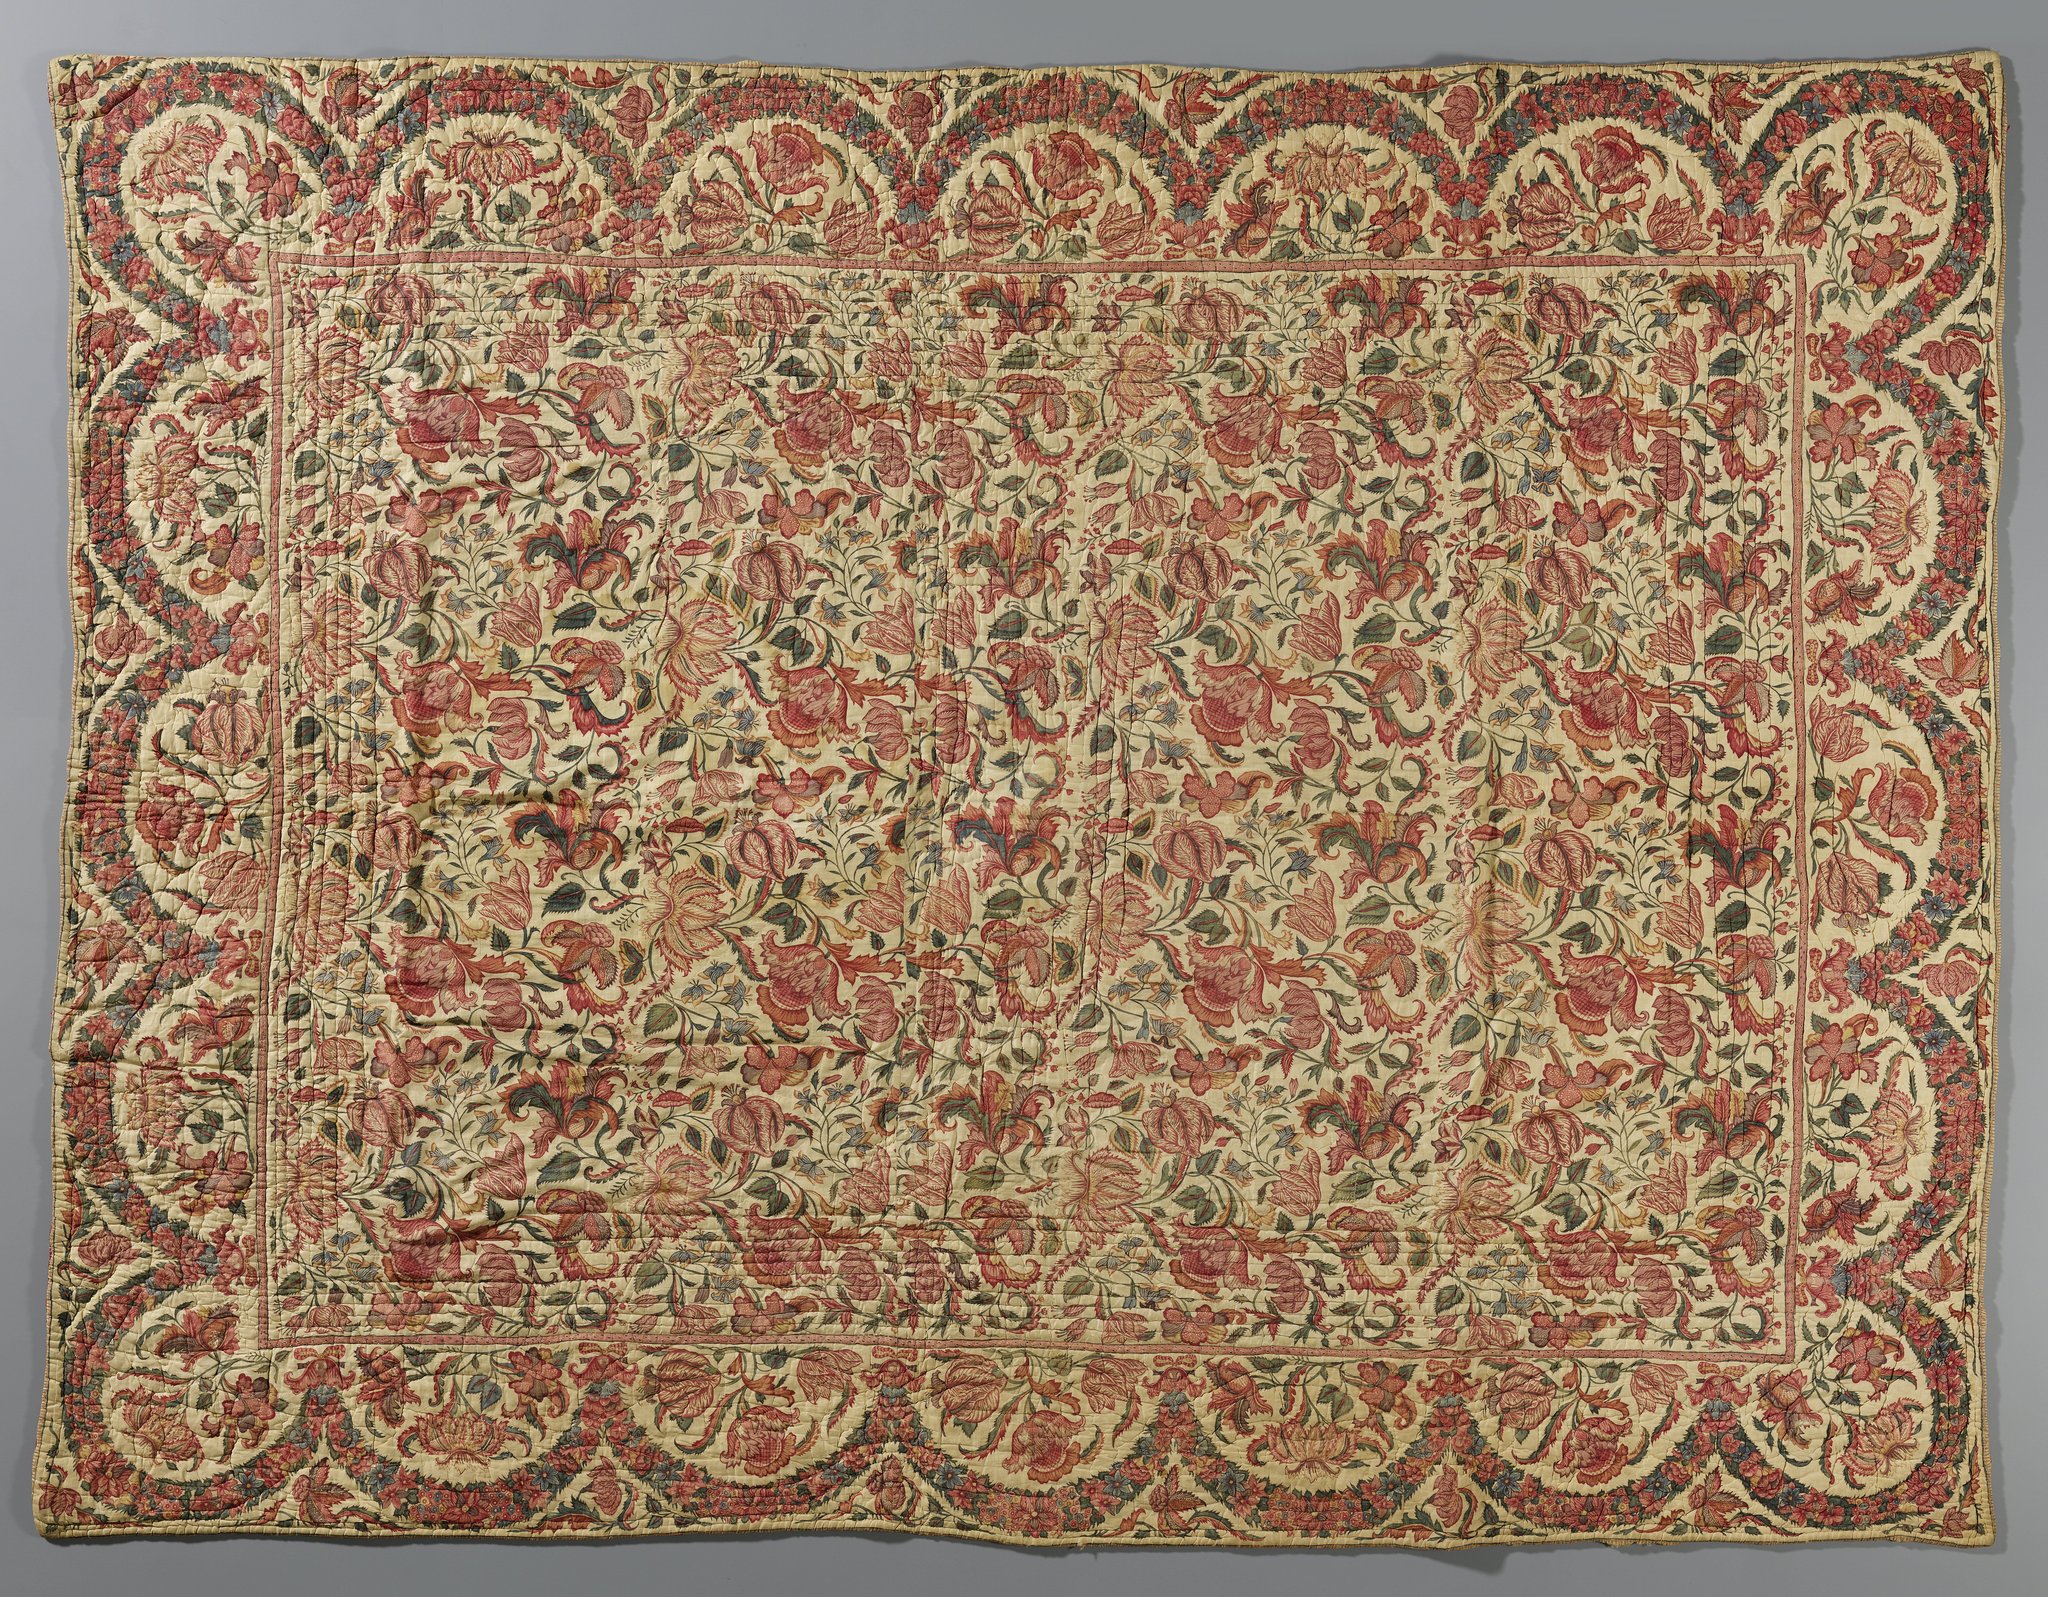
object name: bedspread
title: Sitsen sprei met een rand van guirlandes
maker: Anonymous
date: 1700-1725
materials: cotton, silk, textile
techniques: printing, weave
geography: coromandel coast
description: Sitsen sprei met een rechthoekig middenveld gevuld met bloemtakken. Langs het middenveld loopt een rand die gevuld is met een aaneengesloten slinger guirlandes waartussen rode strikken. De bogen zijn gevuld met bloemen. De sprei is gevoerd met rode tafzijde. Oosterse textiel.